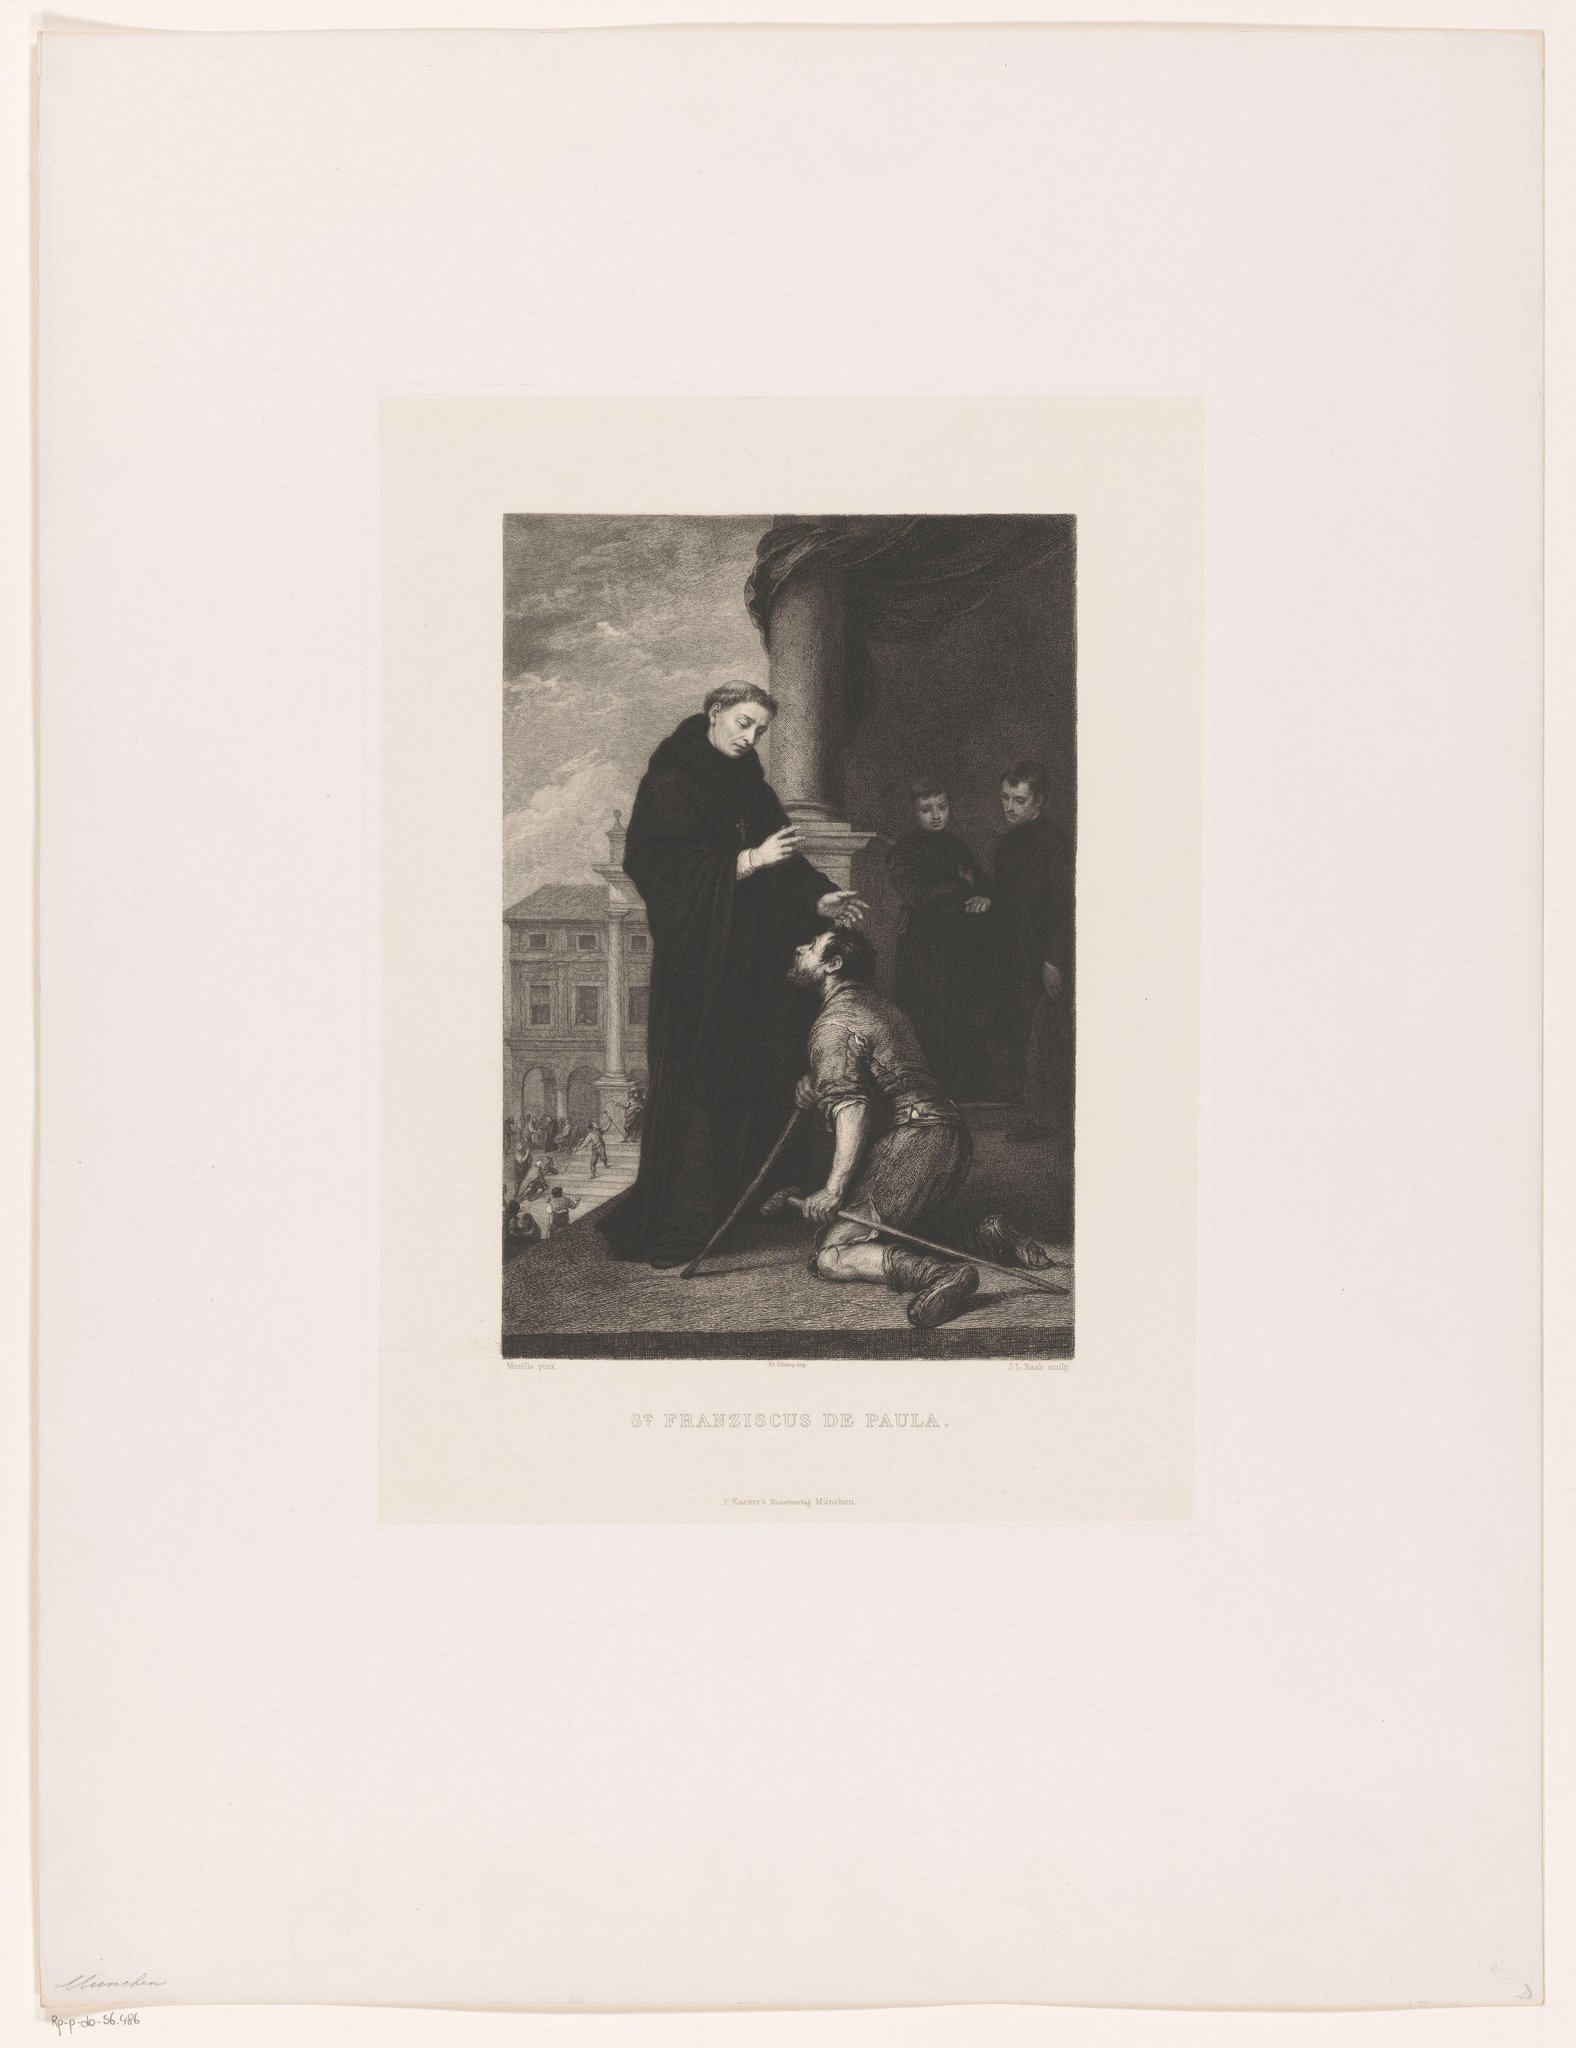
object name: print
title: St. Franziscus de Paula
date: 1835-1899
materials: paper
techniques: etching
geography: munich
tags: miraculous activities and events ~ st. francis of paola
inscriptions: number: ‘10’, collector's mark: Lugt 2228